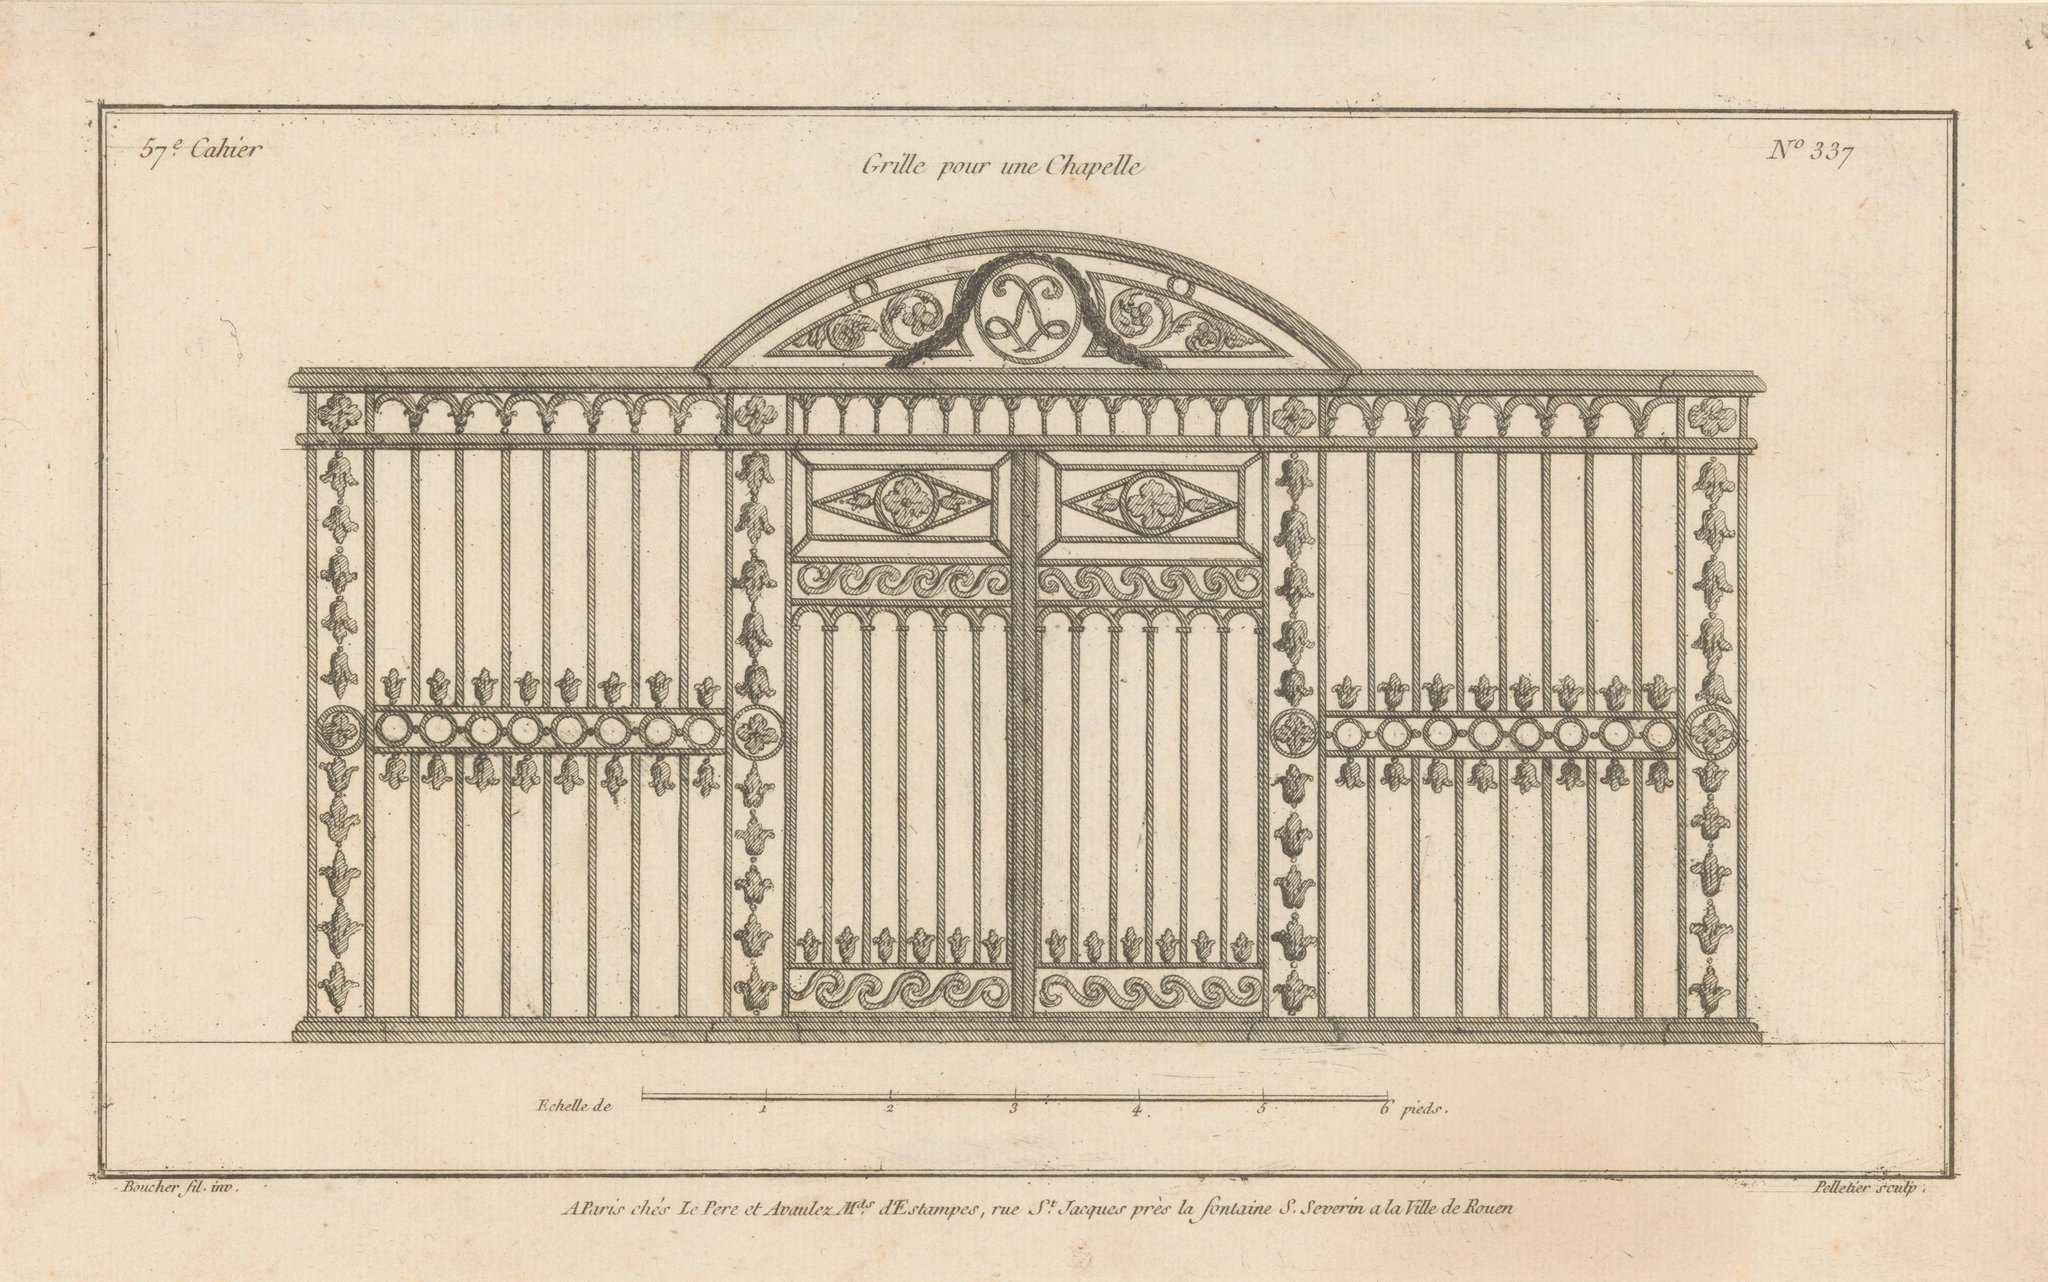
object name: ornament print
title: Hek met bloemmotieven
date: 1772-1779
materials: paper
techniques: engraving, etching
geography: paris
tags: fence, wall, paling, flowers ~ ornament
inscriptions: collector's mark: Lugt 2228, collector's mark: Lugt 2760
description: Een smeedijzeren hek met bloemmotieven. Prentnummer 337.